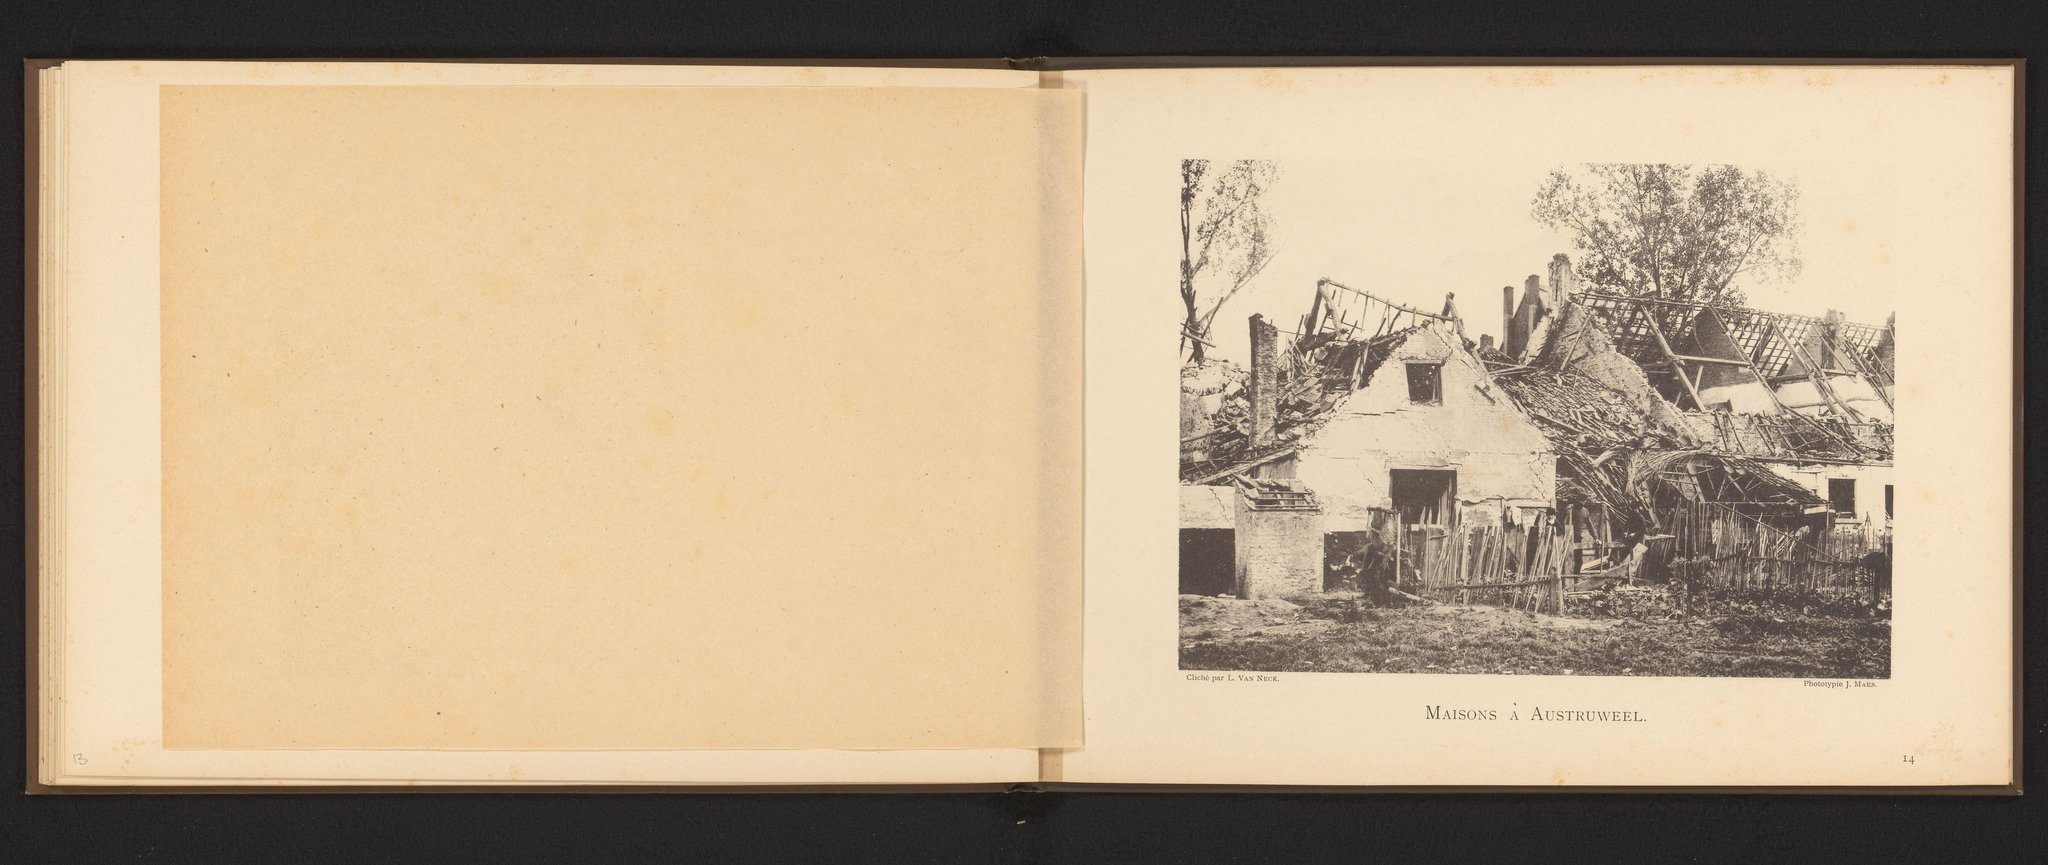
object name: page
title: Maisons à Austruweel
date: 1889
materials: paper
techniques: photograph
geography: antwerp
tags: ruin of a building ~ architecture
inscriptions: number: ‘14’